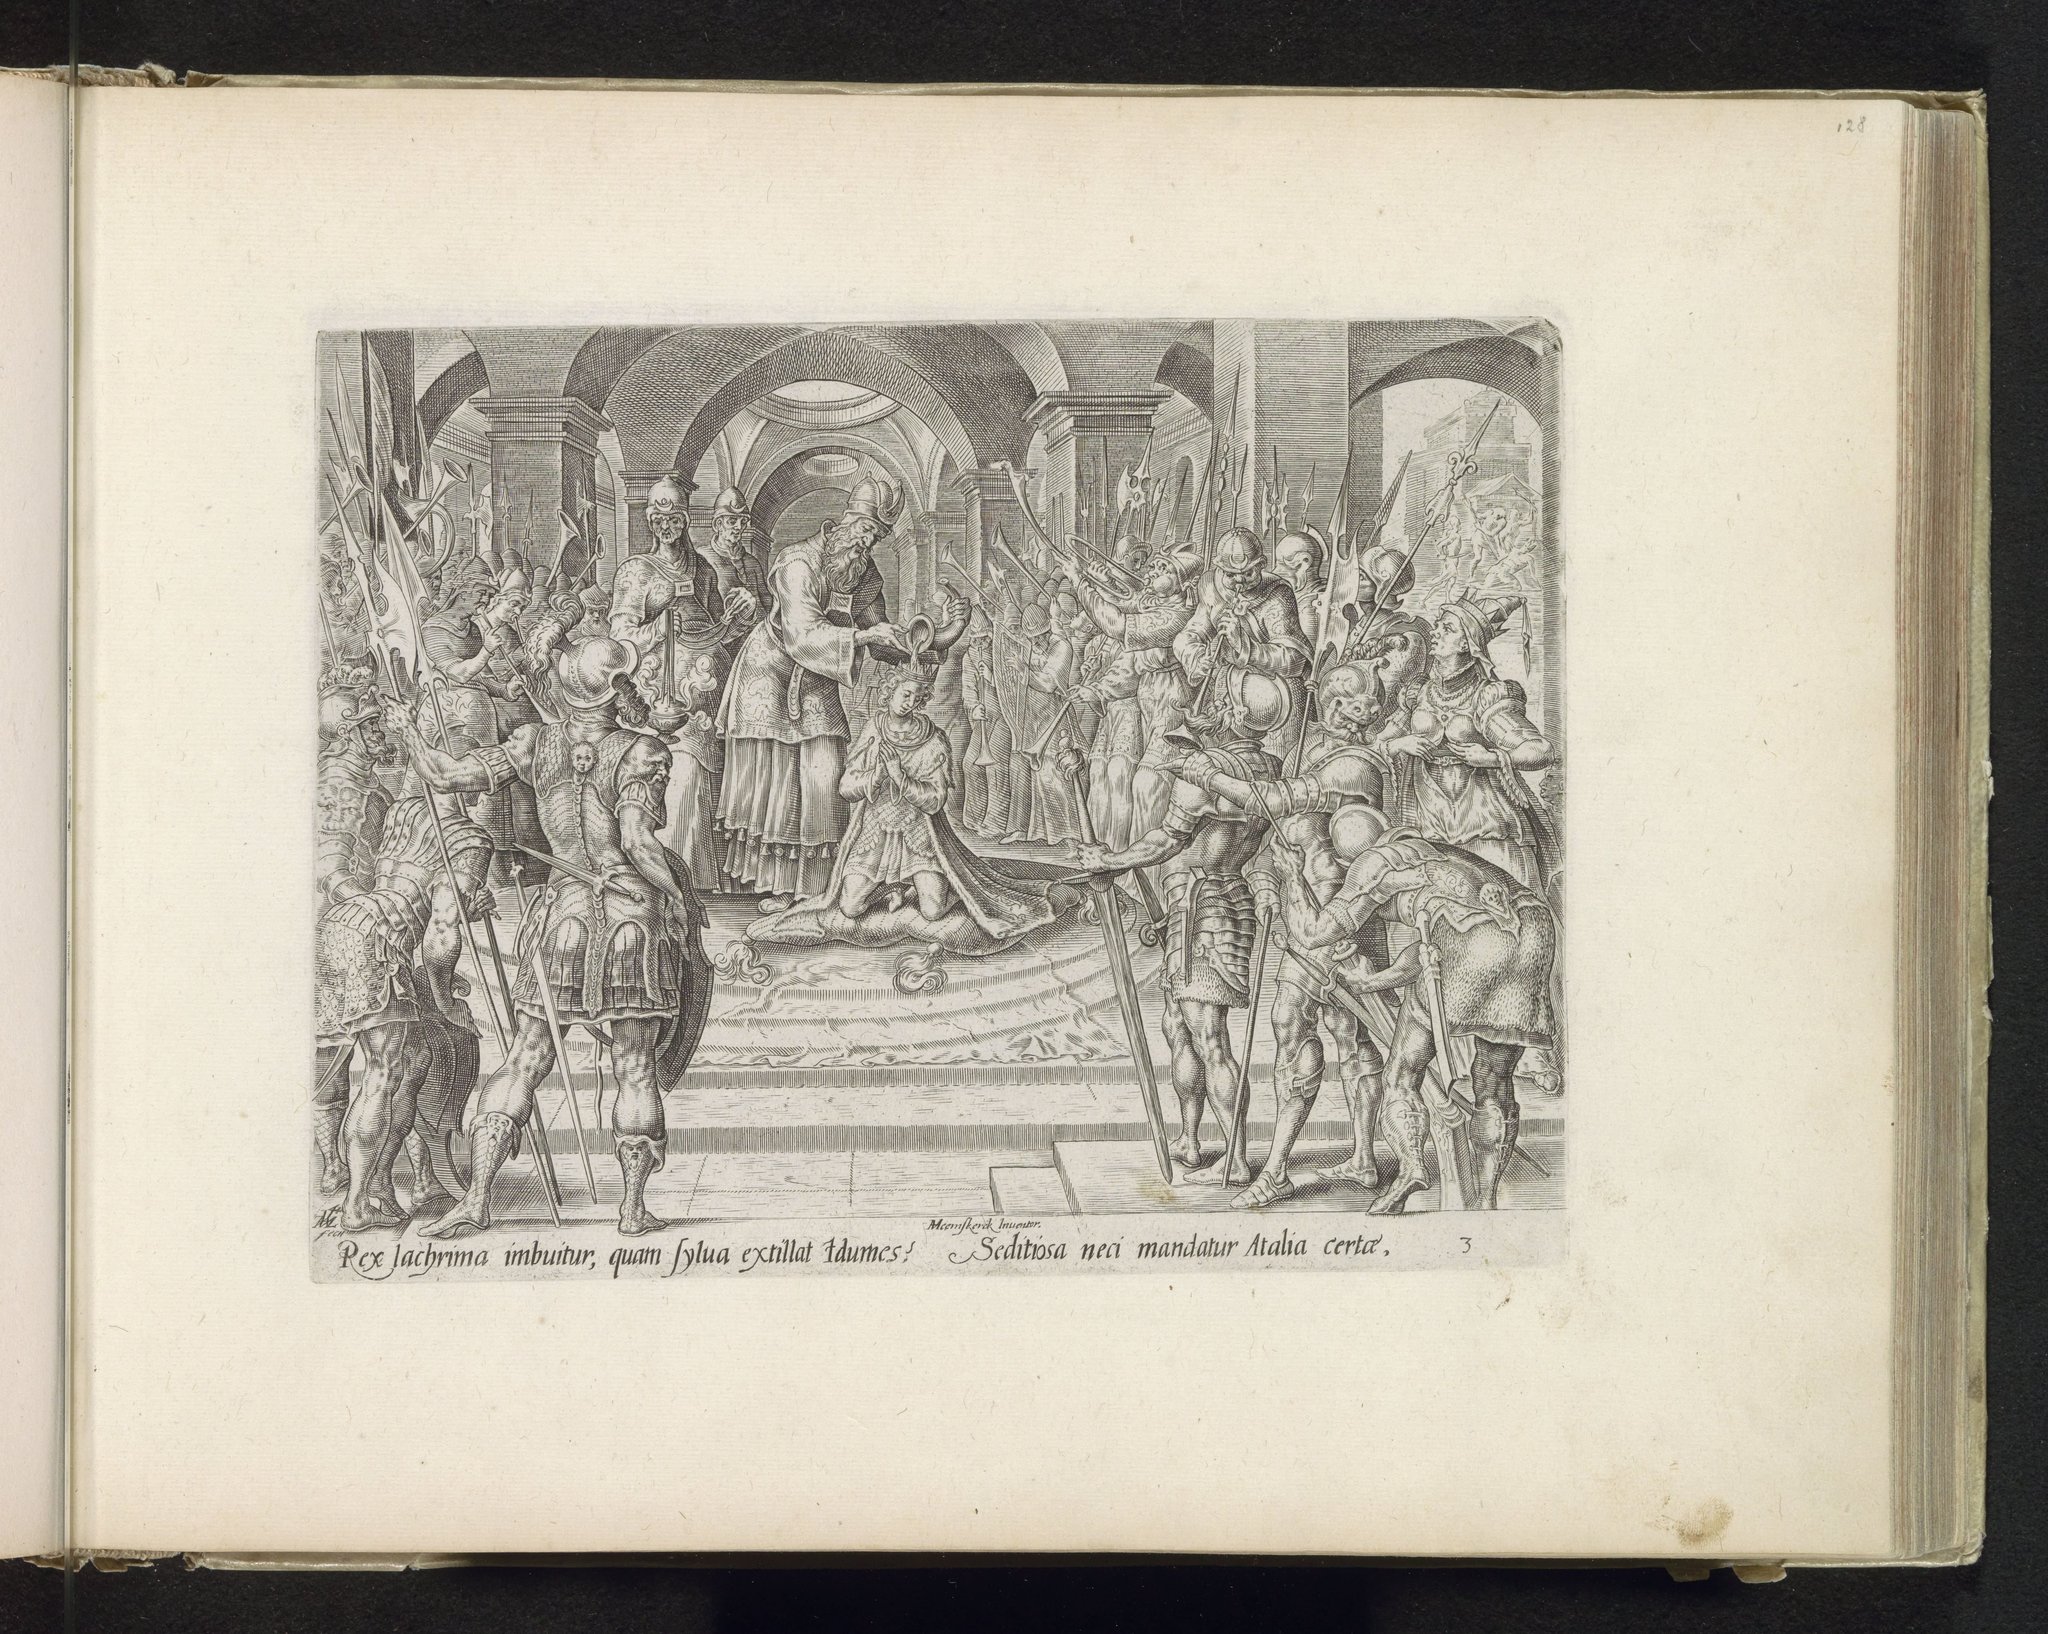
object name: album leaf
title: Thesaurus sacrarum historiaru[m] veteris testame[n]ti, elega[n]tissimis imaginibus expressu[m] excelle[n]tissimoru[m] in hac arte viroru[m] opera: nu[n]c primu[m] in luce[m] editus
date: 1585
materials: paper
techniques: engraving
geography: amsterdam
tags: death of athalia: she is seized by soldiers, brought to the palace and killed at the horse gate, joash, protected by the soldiers, is crowned and anointed king; the people acclaim him, athalia hearing the noise of the people acclaiming king joash, comes to the temple and sees the new king standing by a pillar; she tears her clothes in dismay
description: De hogepriester Jojada giet zalfolie over het hoofd van Joas en roept hem uit tot koning. Omstanders blazen op trompetten en bespelen de harp. Tussen de soldaten rechts kijkt koningin Atalja toe, terwijl ze haar kleren scheurt. Rechts in de achtergrond wordt koningin Atalja gedood. Onderaan in de marge een vers in het Latijn over de voorstelling. Deze prent maakt deel uit van een album.